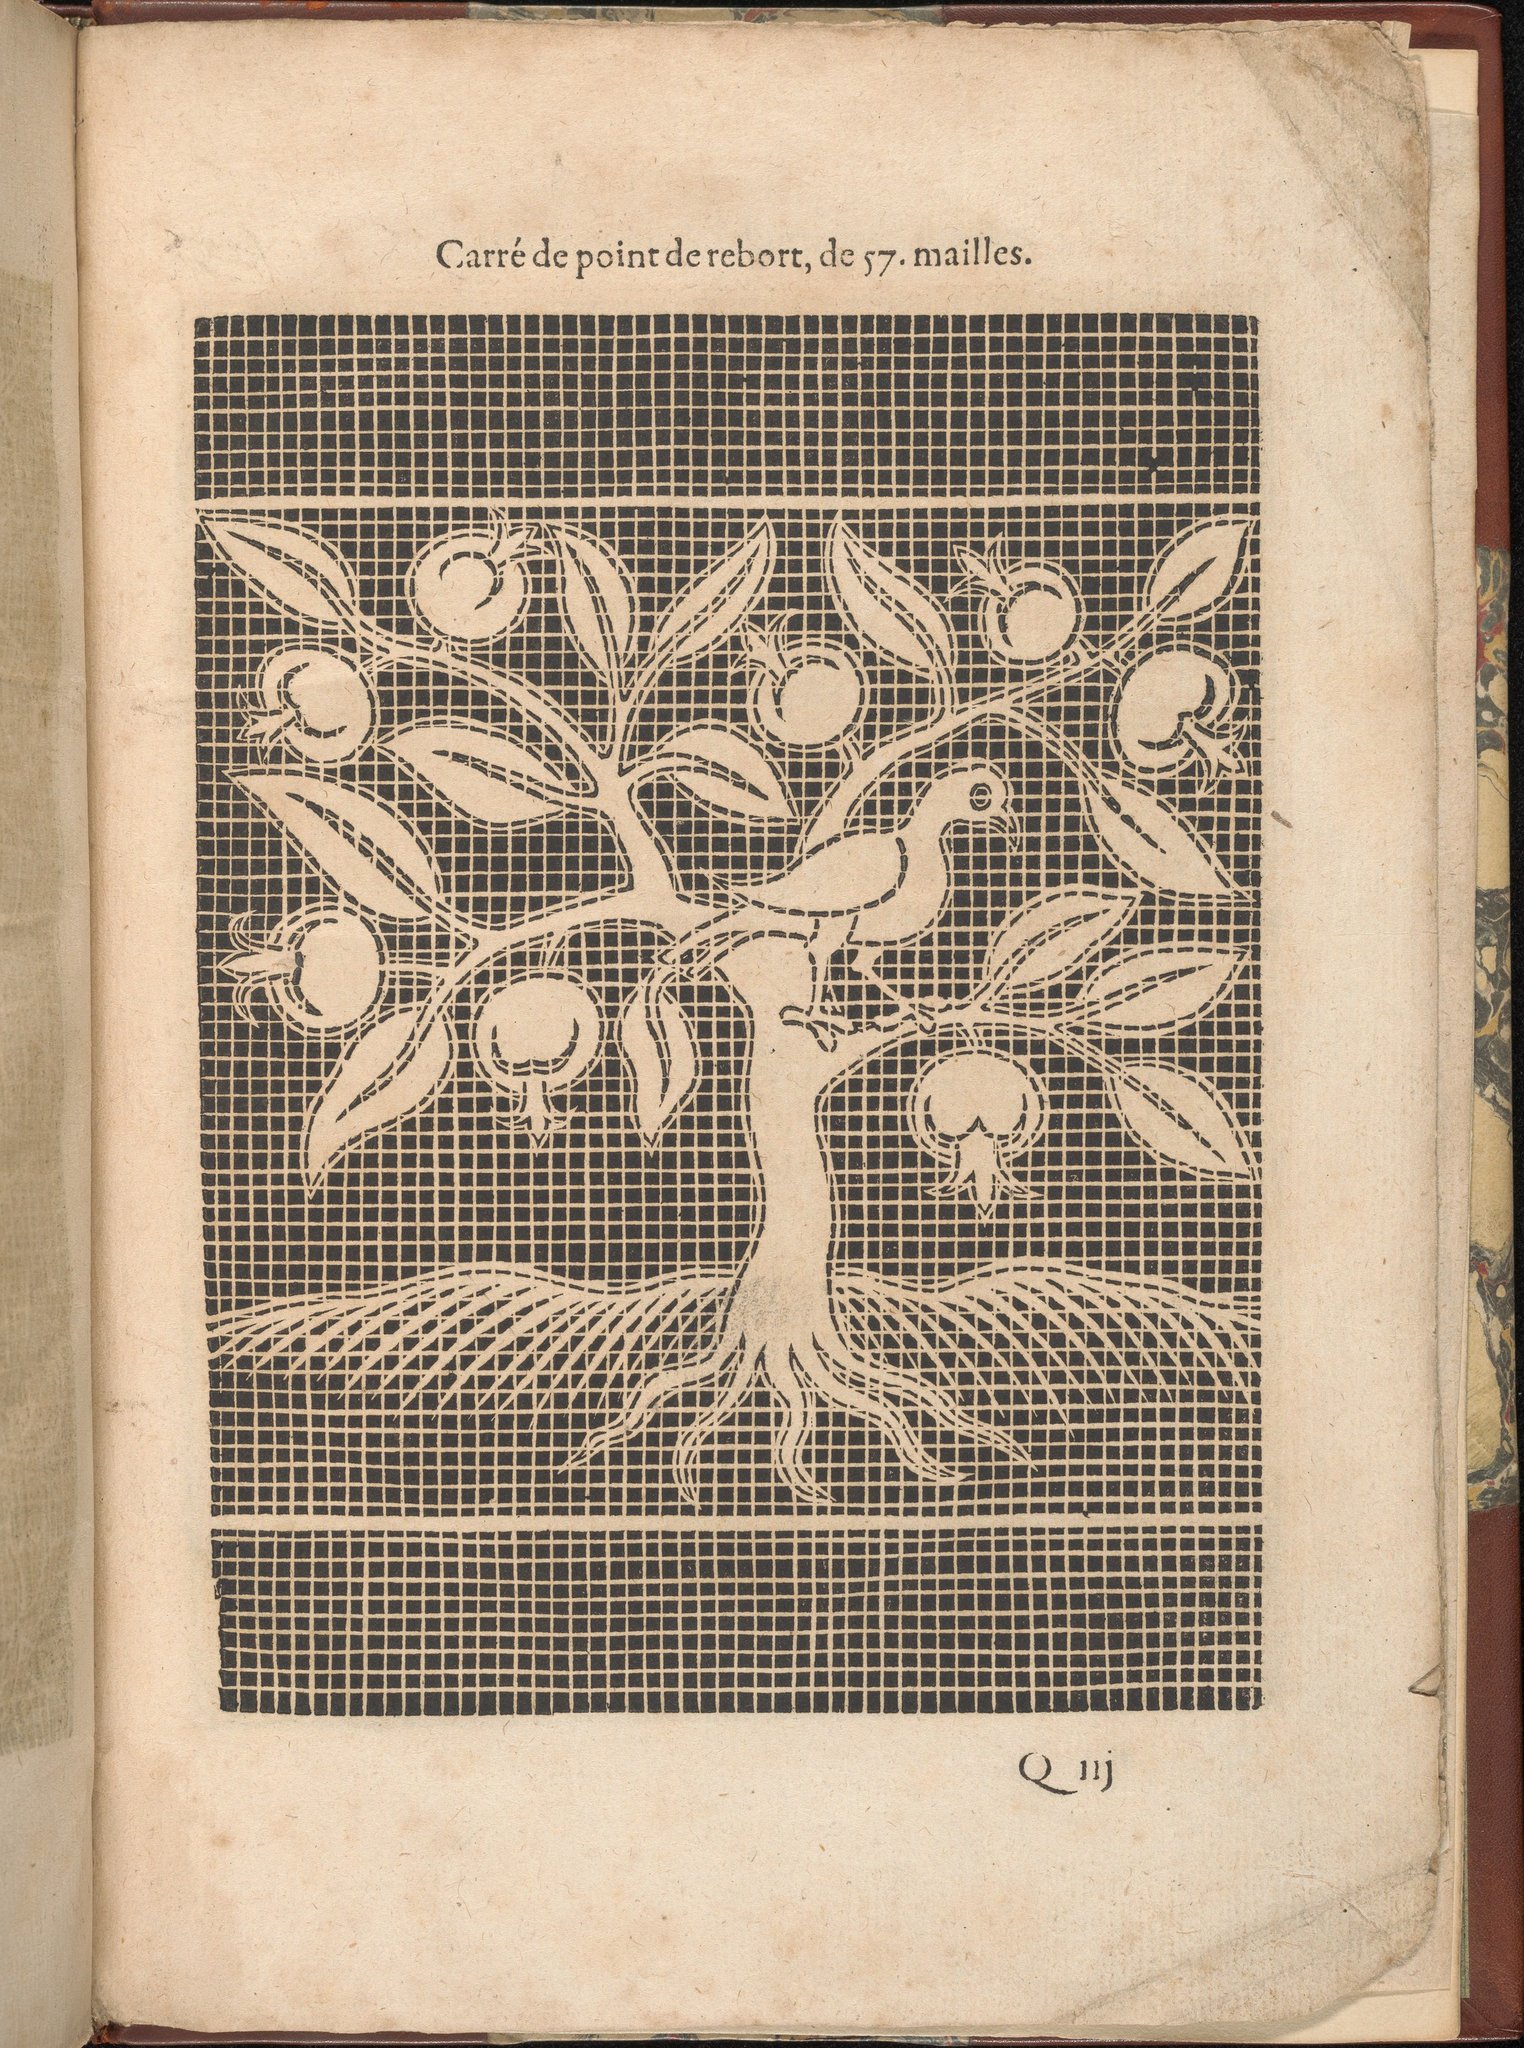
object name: book print ornament architecture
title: Les Secondes Oeuvres, et Subtiles Inventions De Lingerie du Seigneur Federic de Vinciolo Venitien, page 63 (recto)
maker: federico de vinciolo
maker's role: designer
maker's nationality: italian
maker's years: 1582-1599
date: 1603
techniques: woodcut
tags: birds,fruit